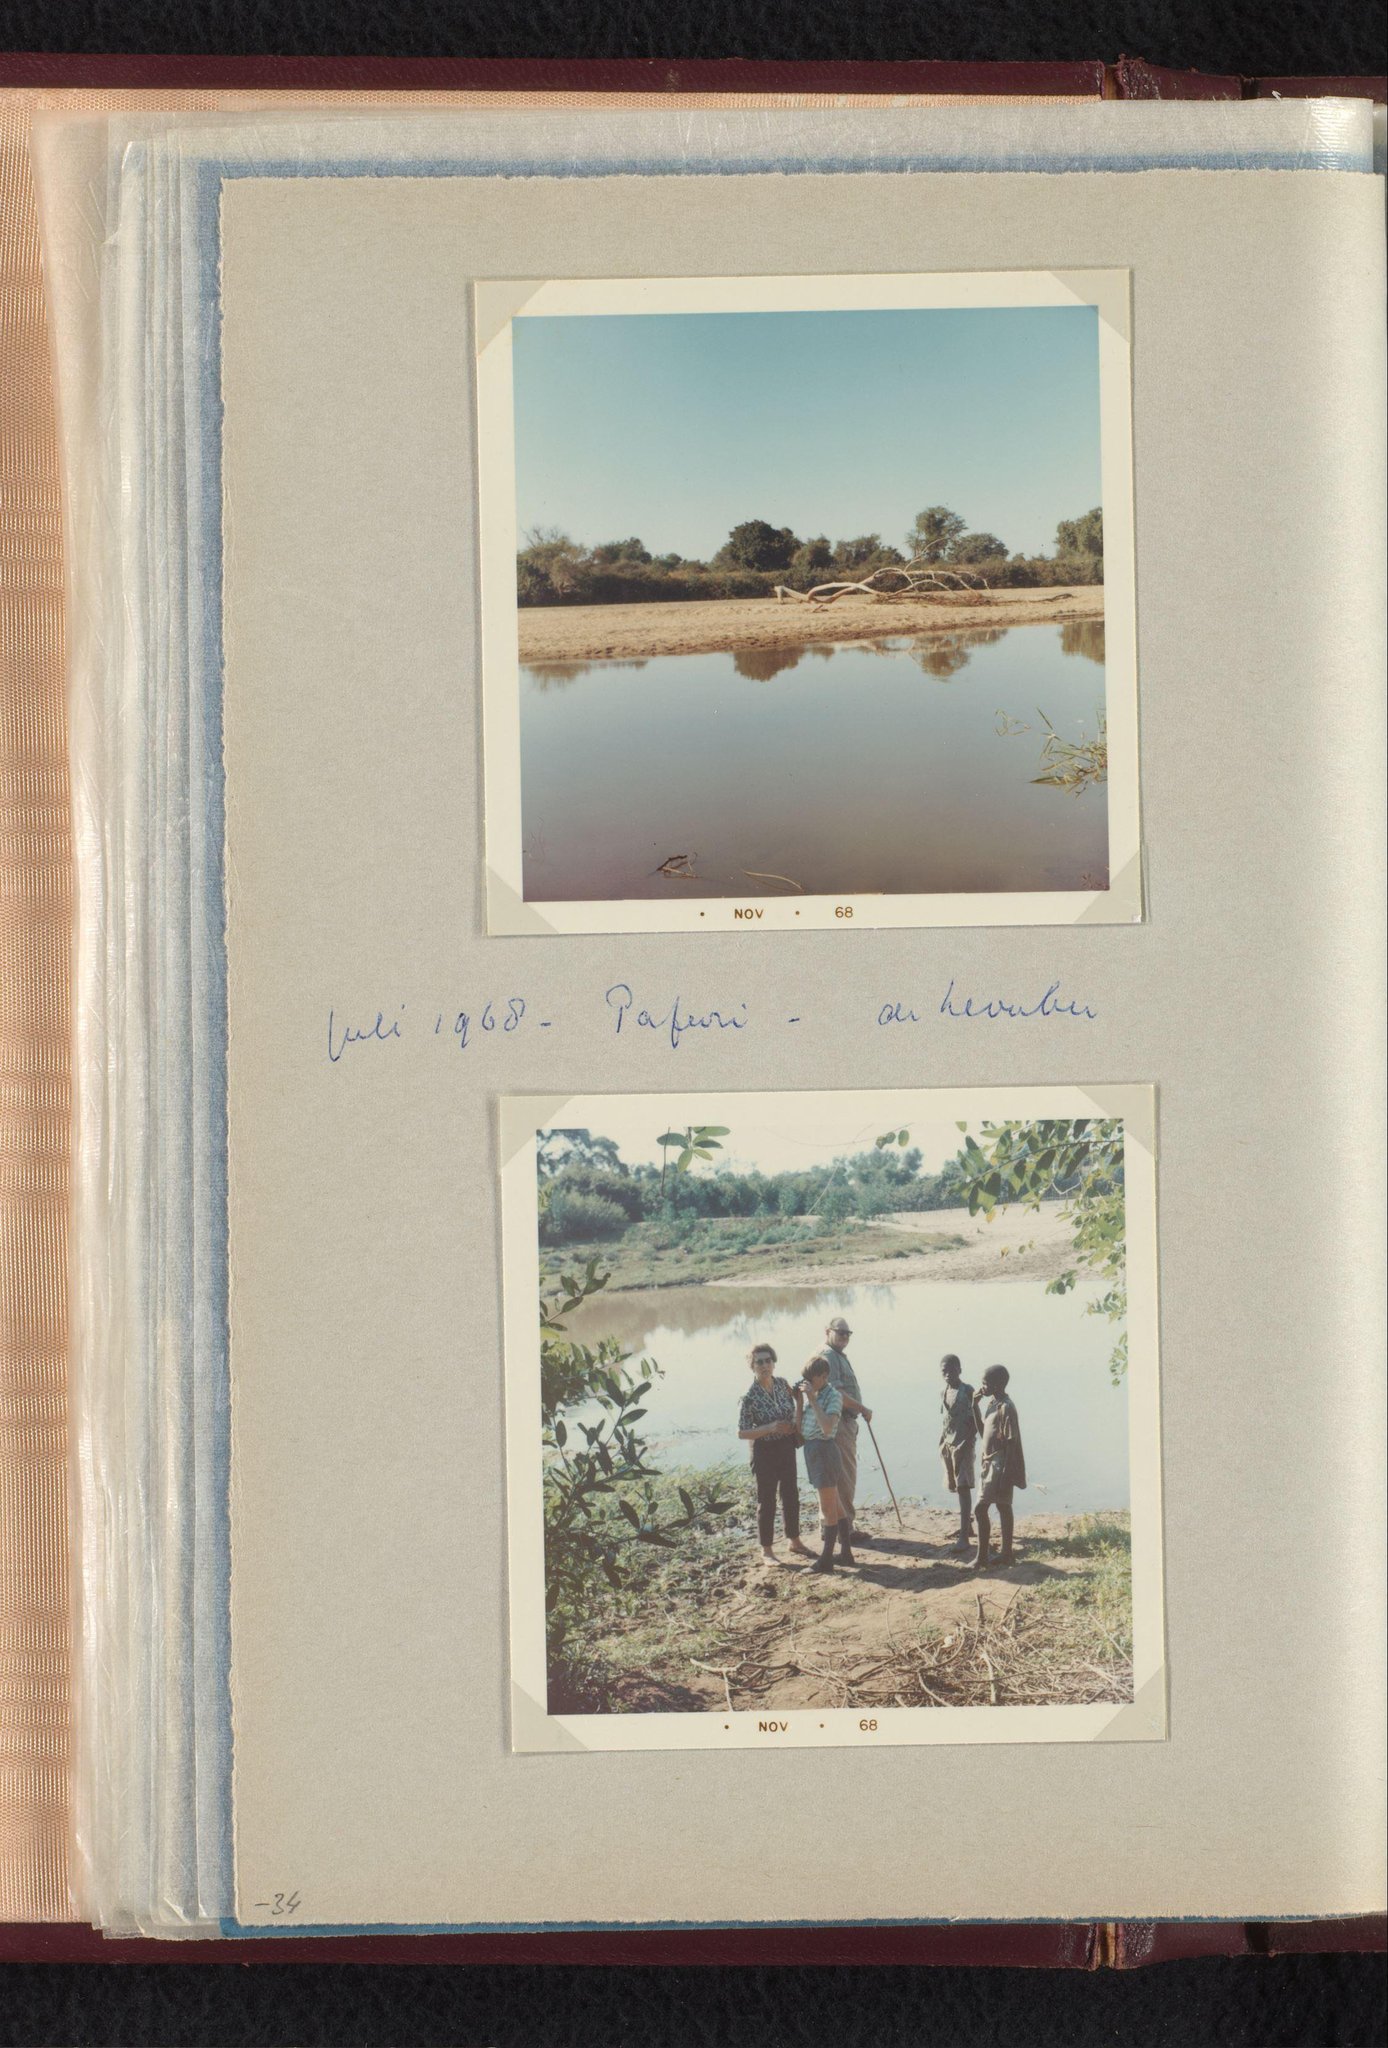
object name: photograph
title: Willem van den Berg met een vrouw en een jongen bij een rivier in Makuleke, Zuid-Afrika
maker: willem jacob van den berg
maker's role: boer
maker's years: 1902-1983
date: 1911-1968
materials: paper, cardboard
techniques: chromogenic print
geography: makuleke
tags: amsterdam, willem jacob van den berg, river, forest, wood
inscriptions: inscription: ‘Pafuri - de [?]’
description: Deze foto's zijn onderdeel van een album.